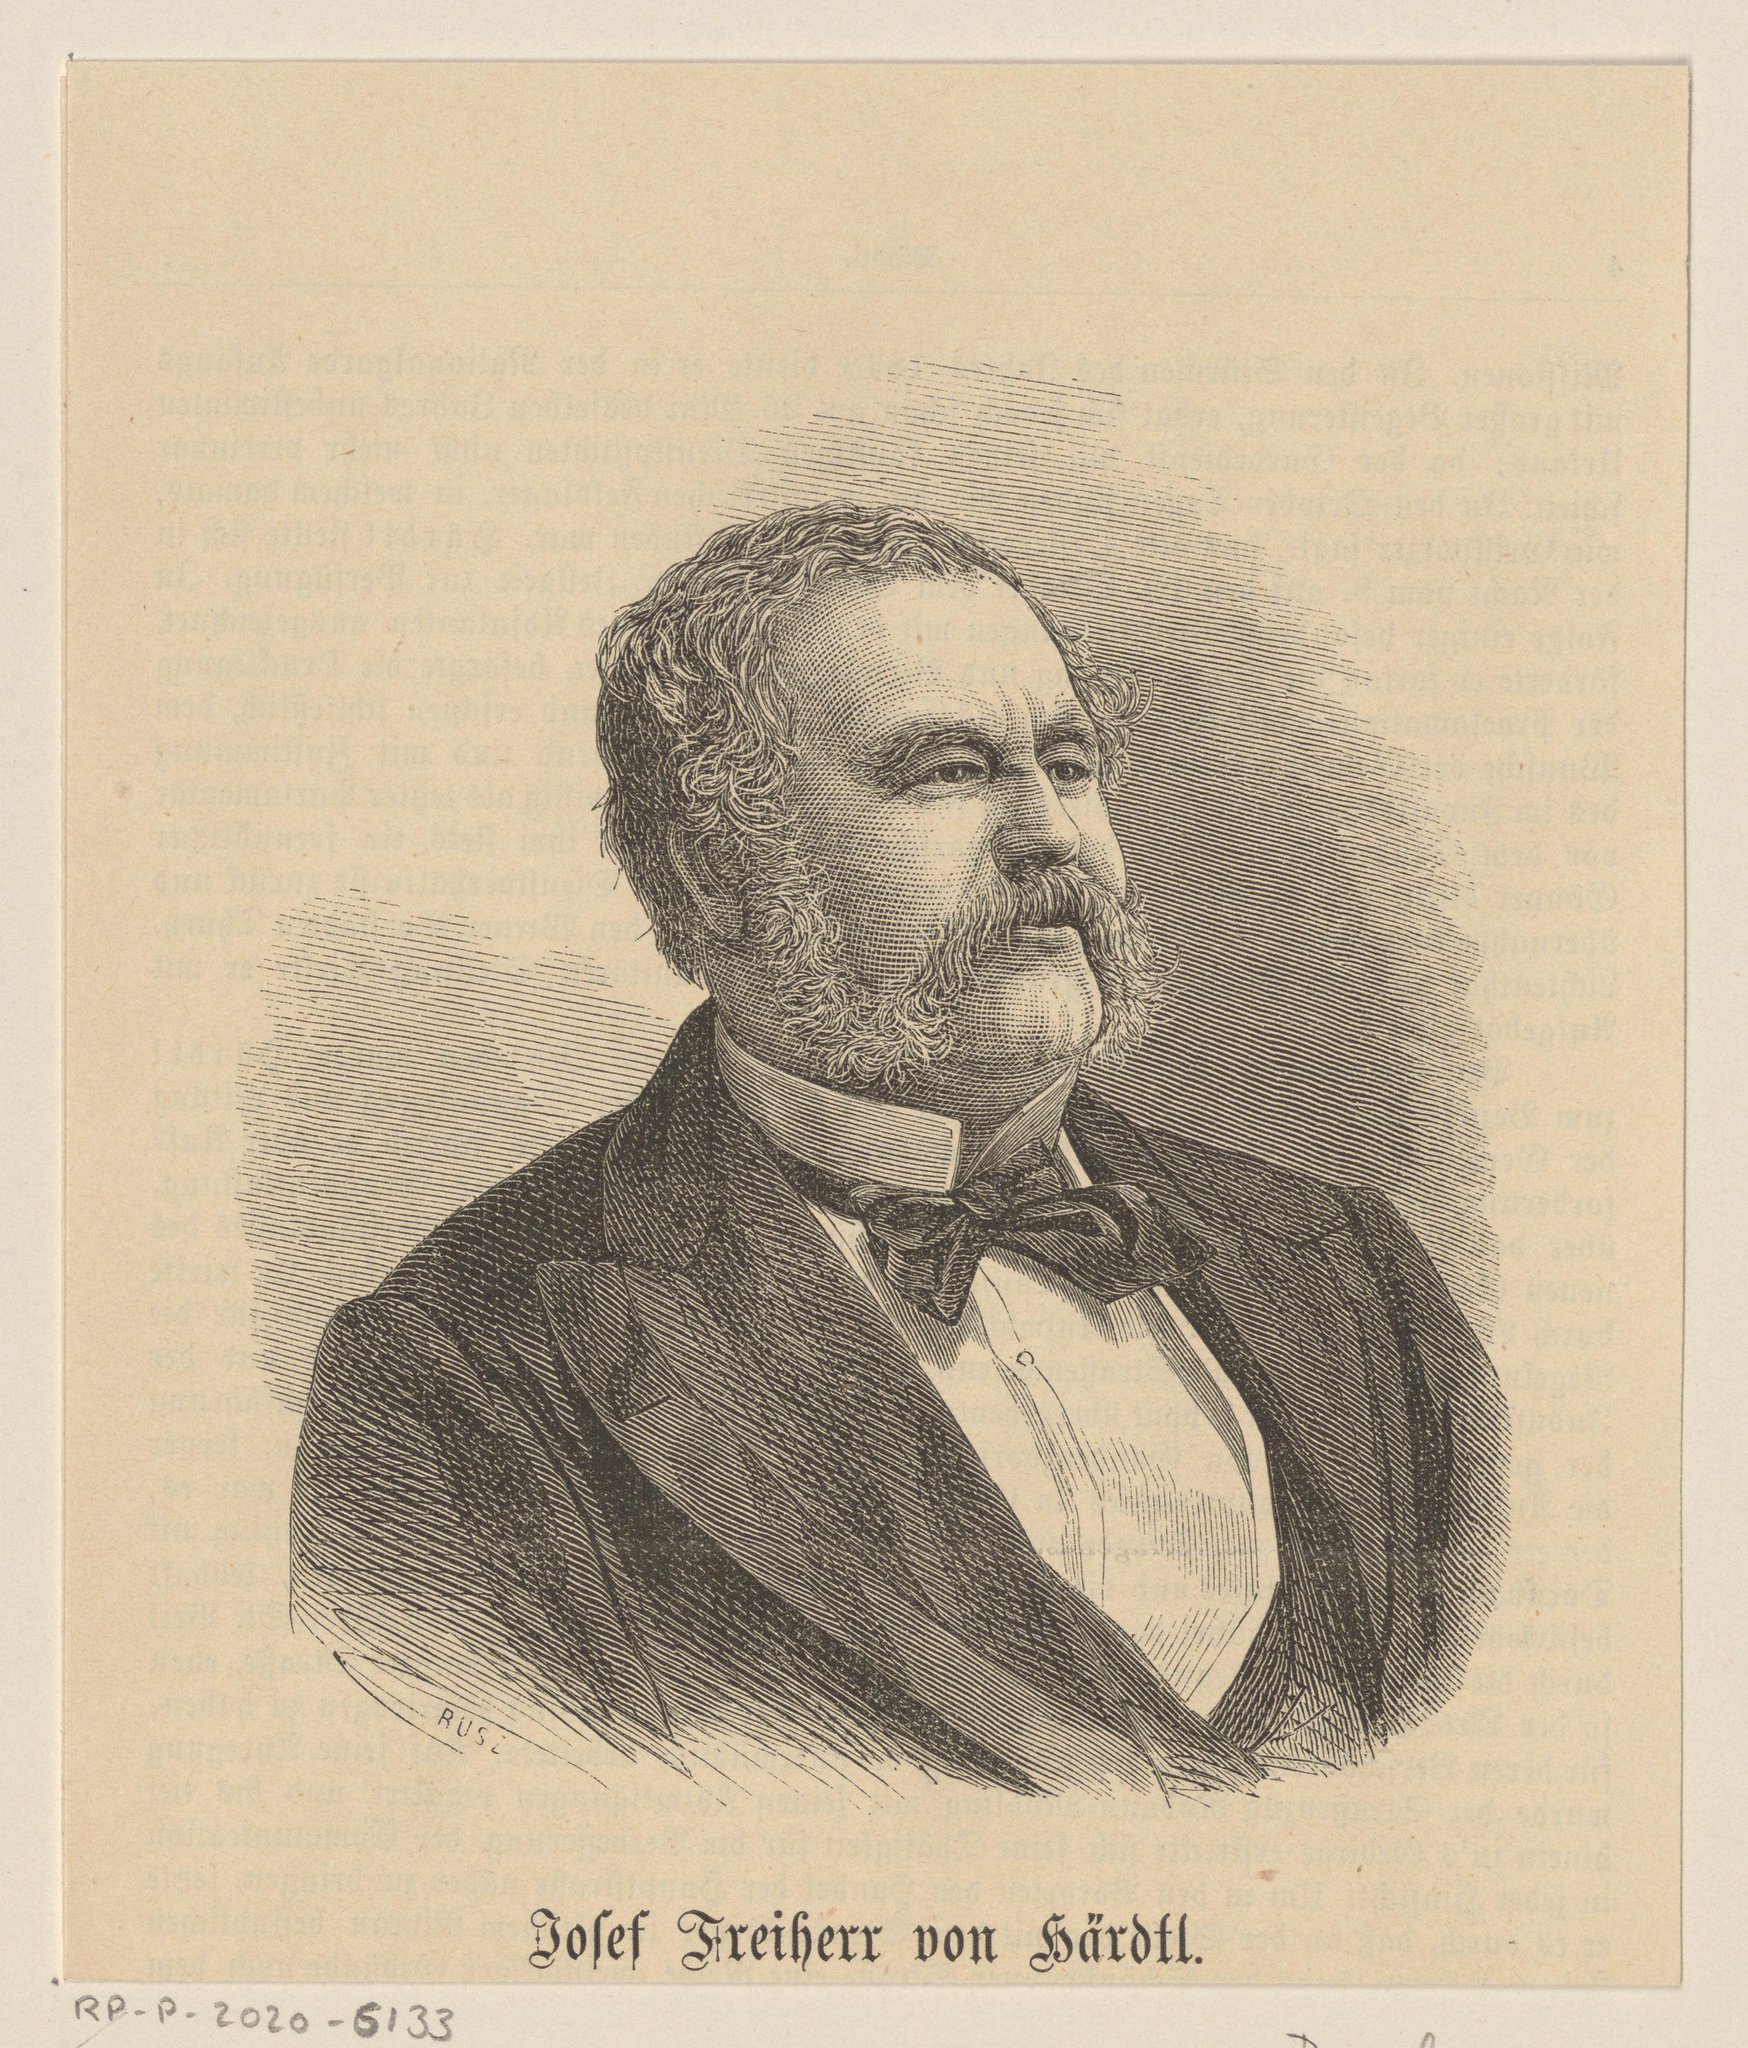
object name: print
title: Portret van Josef von Härdtl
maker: károly rusz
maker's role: print maker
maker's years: 1811-1899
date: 1874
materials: paper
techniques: letterpress printing, engraving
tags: prague, historical persons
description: Prent met andere tekst op verso gebruikt in: Wiener Intelligenzblatt 2 (1874), nr. 19, 10 november 1874.